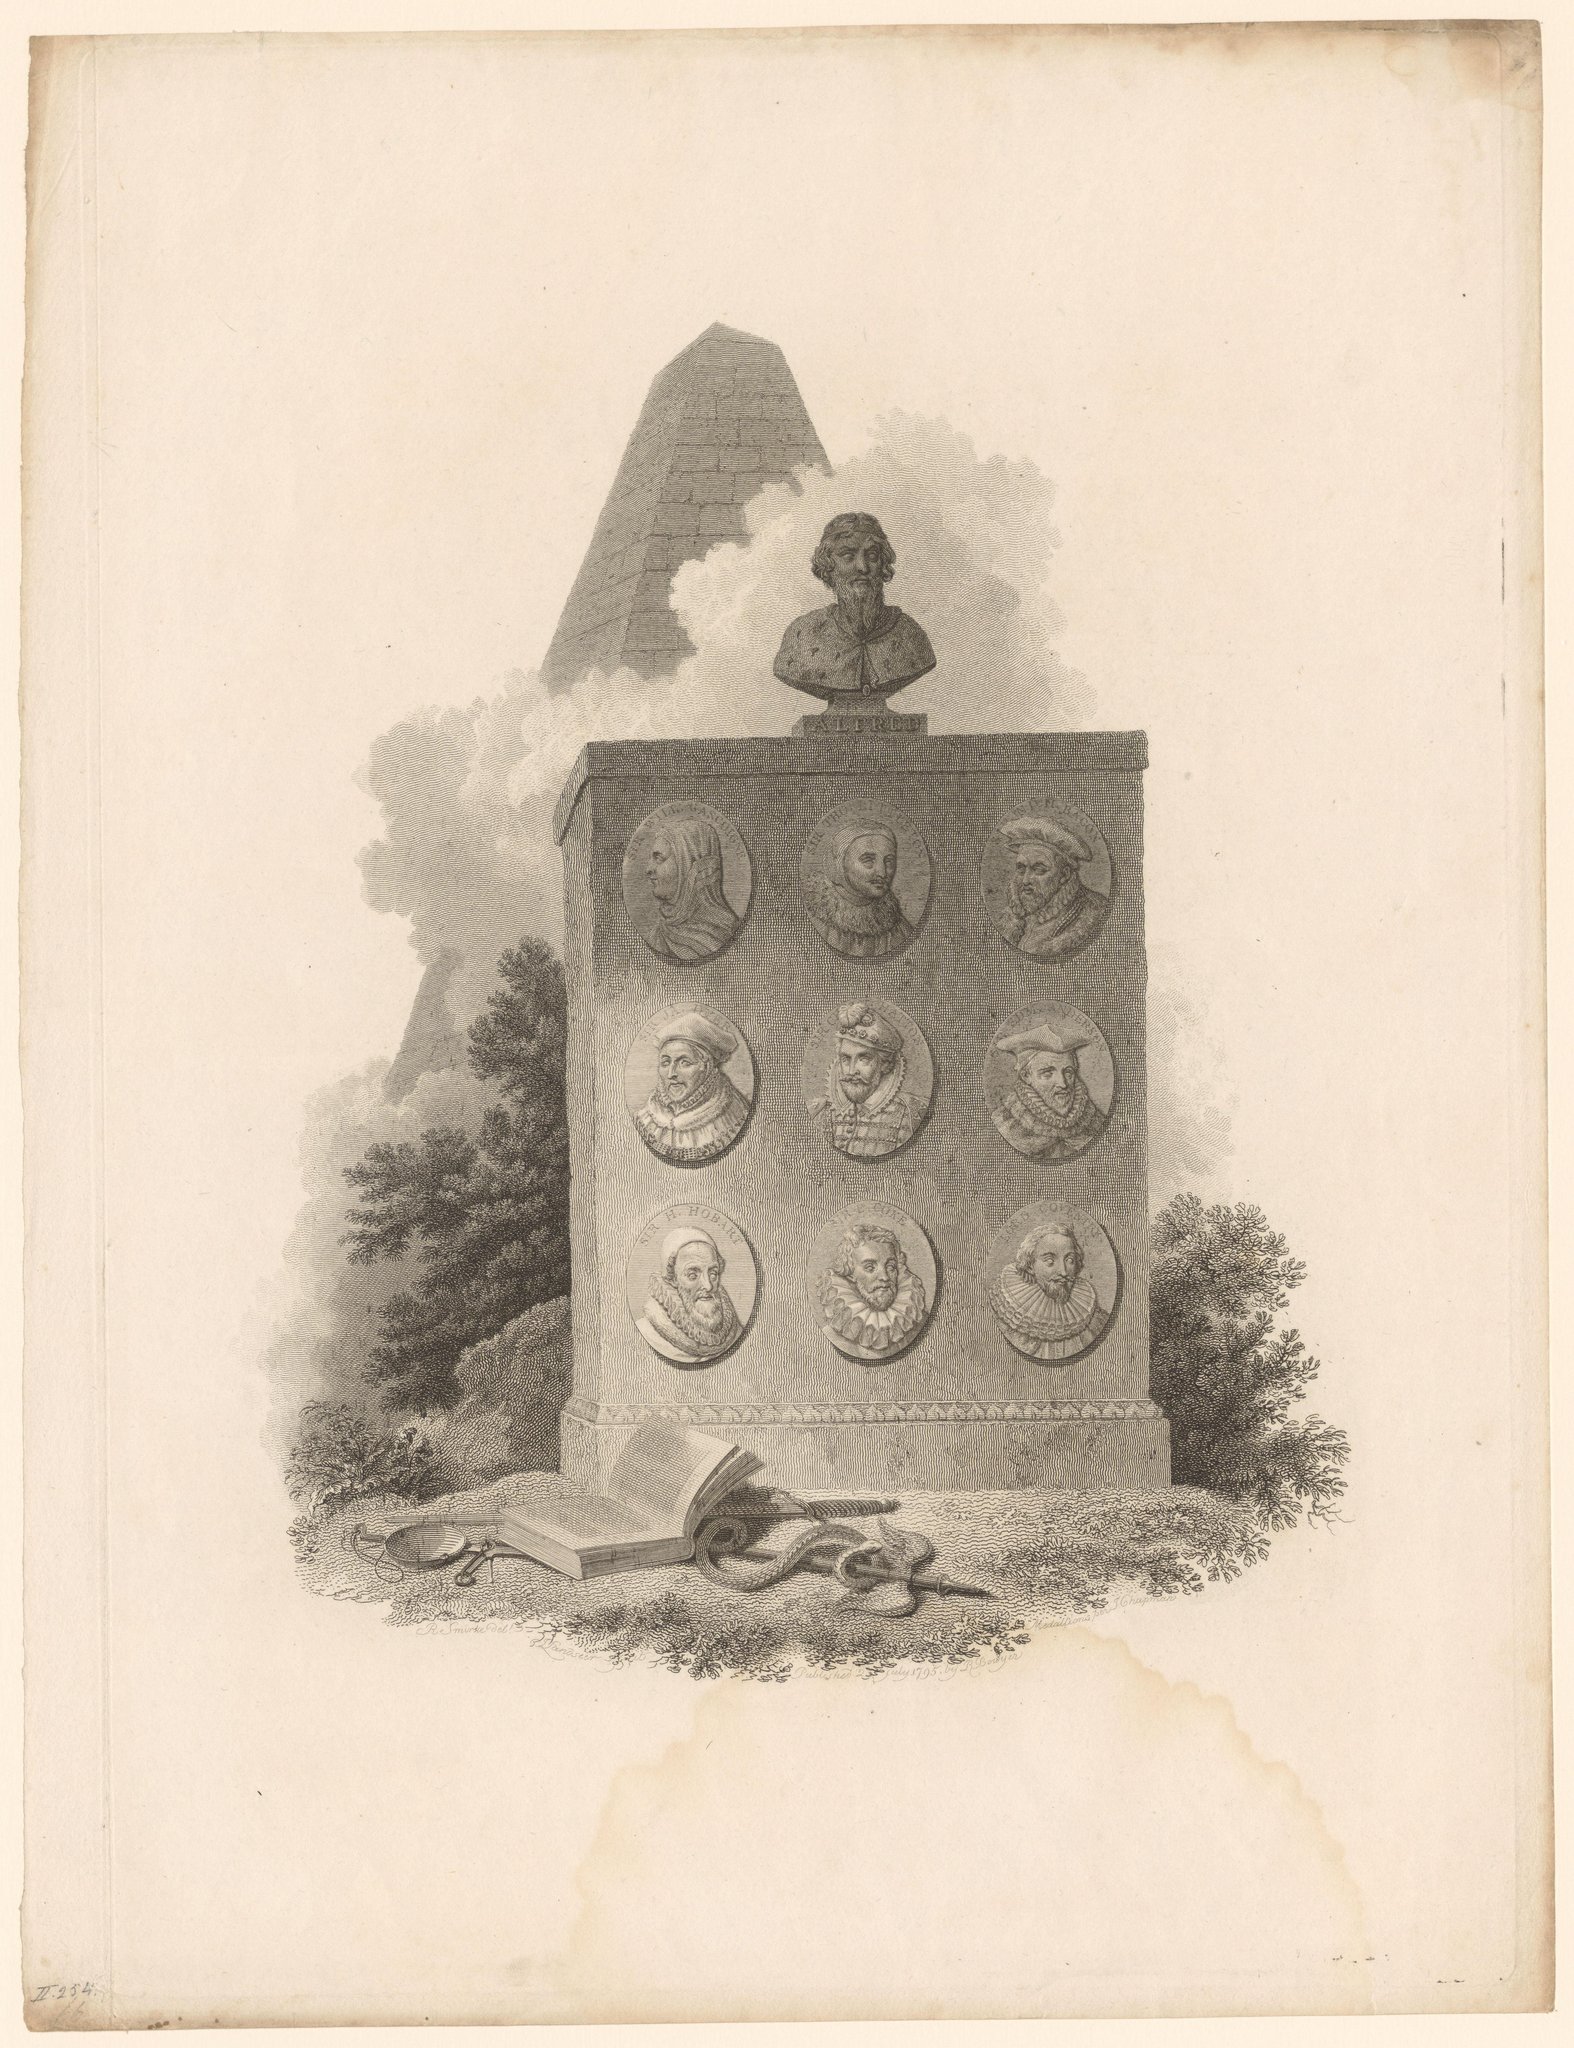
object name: print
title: Monument met negen medaillons met portretten en een buste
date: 1795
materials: paper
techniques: etching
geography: london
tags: politician, historical persons, monument, statue, caduceus (staff with two snakes, attribute of mercury), king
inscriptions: collector's mark: Lugt 2228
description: Vooraan een weegschaal, een zwaard en een caduceus. In de wolken achter het monument een piramide.